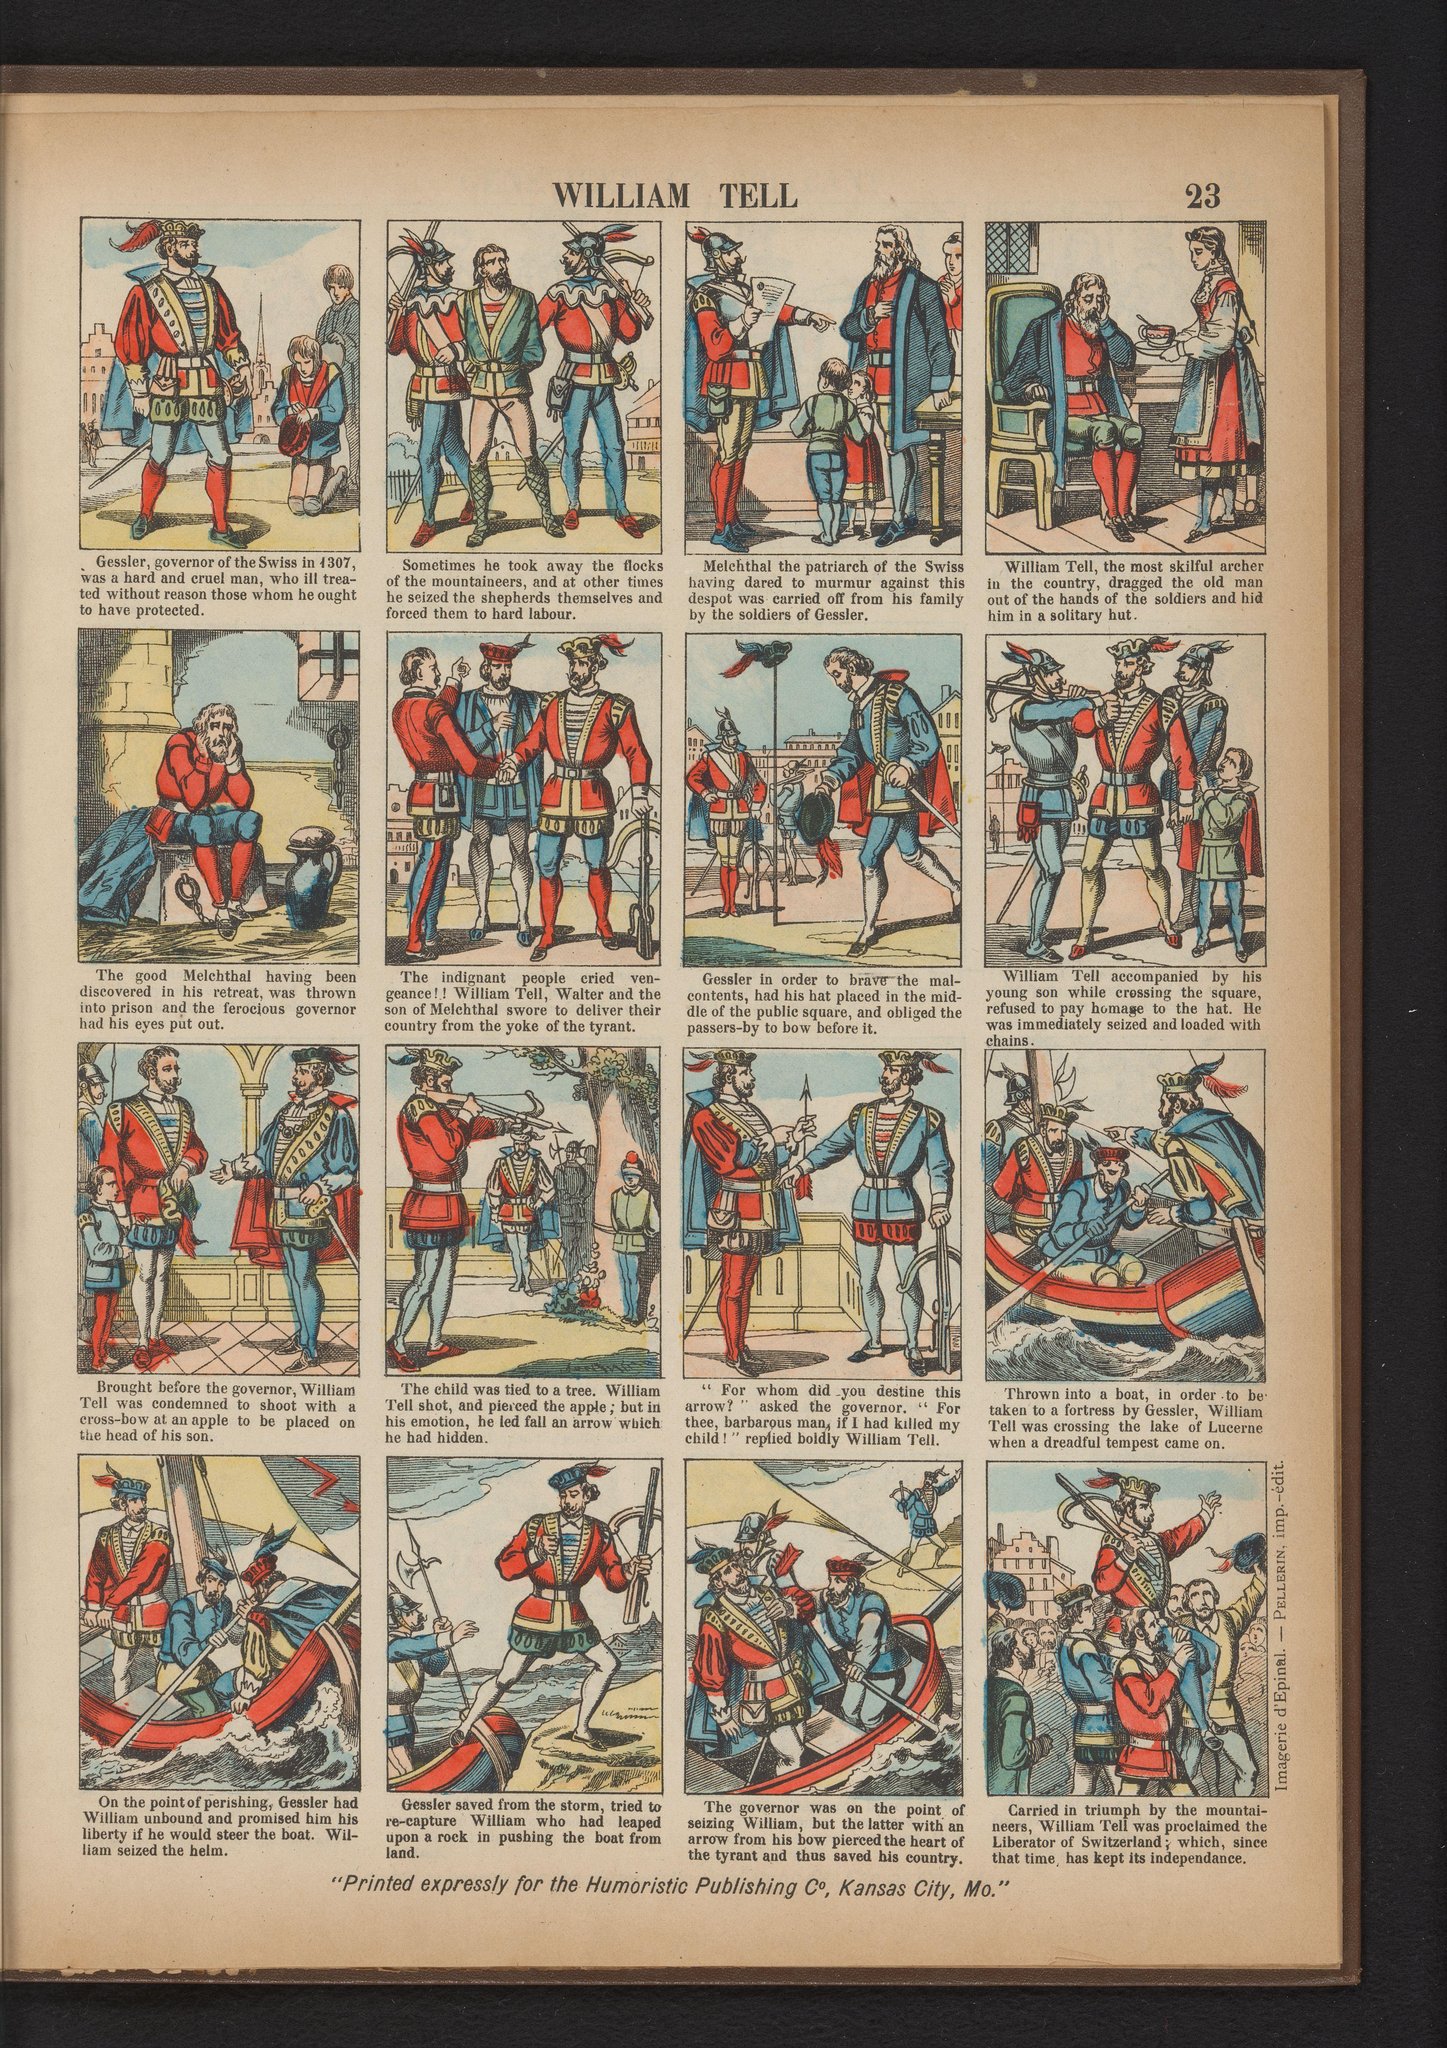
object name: popular print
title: Willem Tell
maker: Anonymous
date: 1893-1894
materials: paper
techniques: colour, letterpress printing, lithograph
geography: epinal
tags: william tell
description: Blad met zestien voorstellingen met het verhaal van Willem Tell. Onder elke voorstelling een onderschrift in het Engels. Deze prent maakt deel uit van een album.